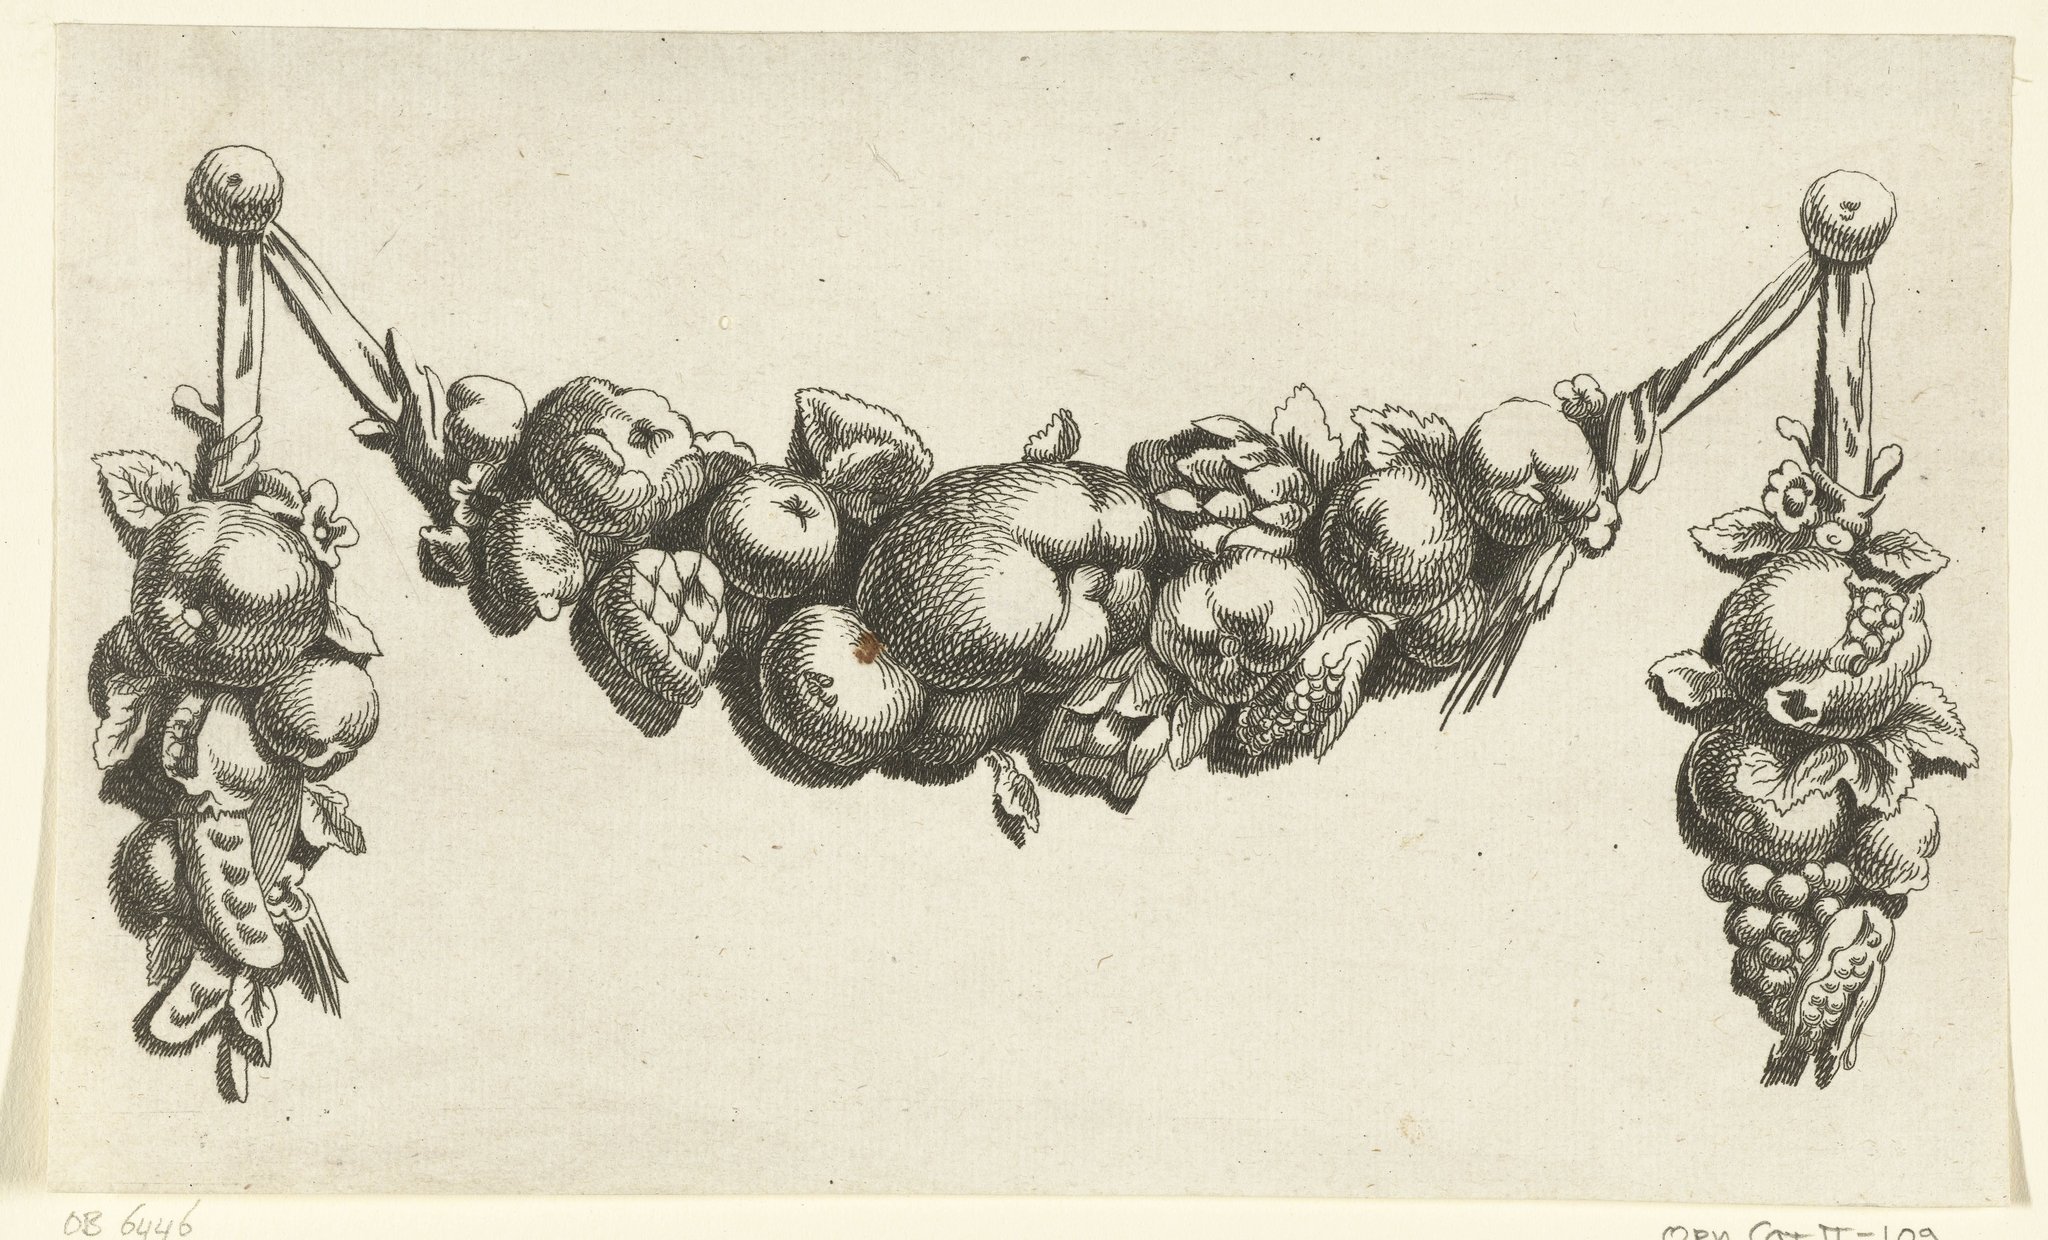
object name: ornament print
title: Nieuwe Festonnen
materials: paper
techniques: etching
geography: amsterdam